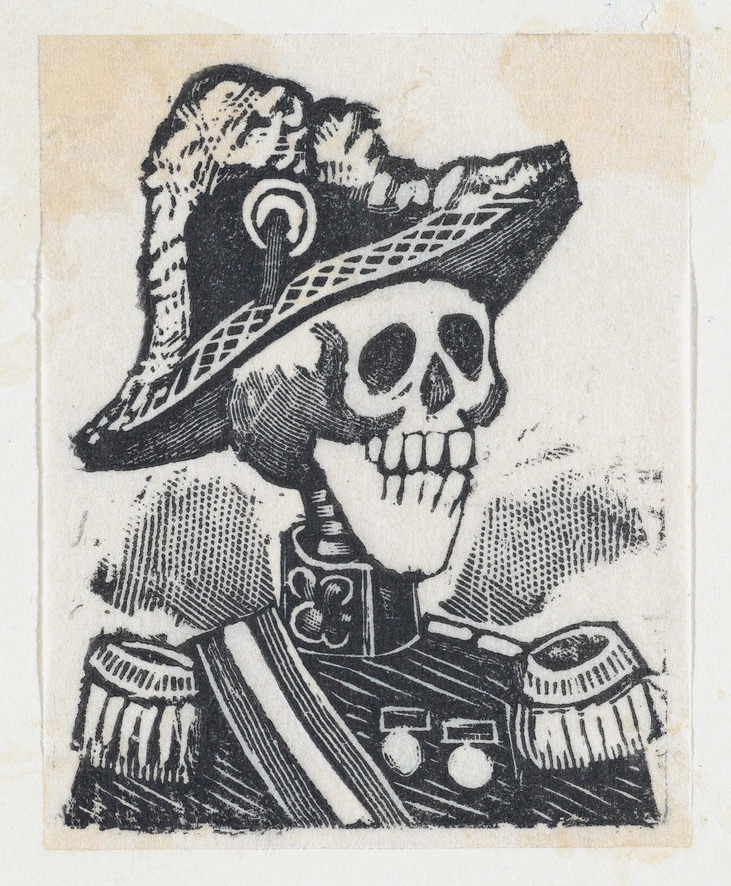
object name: print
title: A skeleton dressed as a military figure (vignette for the feast of the dead)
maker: josé guadalupe posada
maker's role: artist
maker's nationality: mexican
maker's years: 1852-1913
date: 1890-1910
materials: metal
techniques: engraving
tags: skeletons